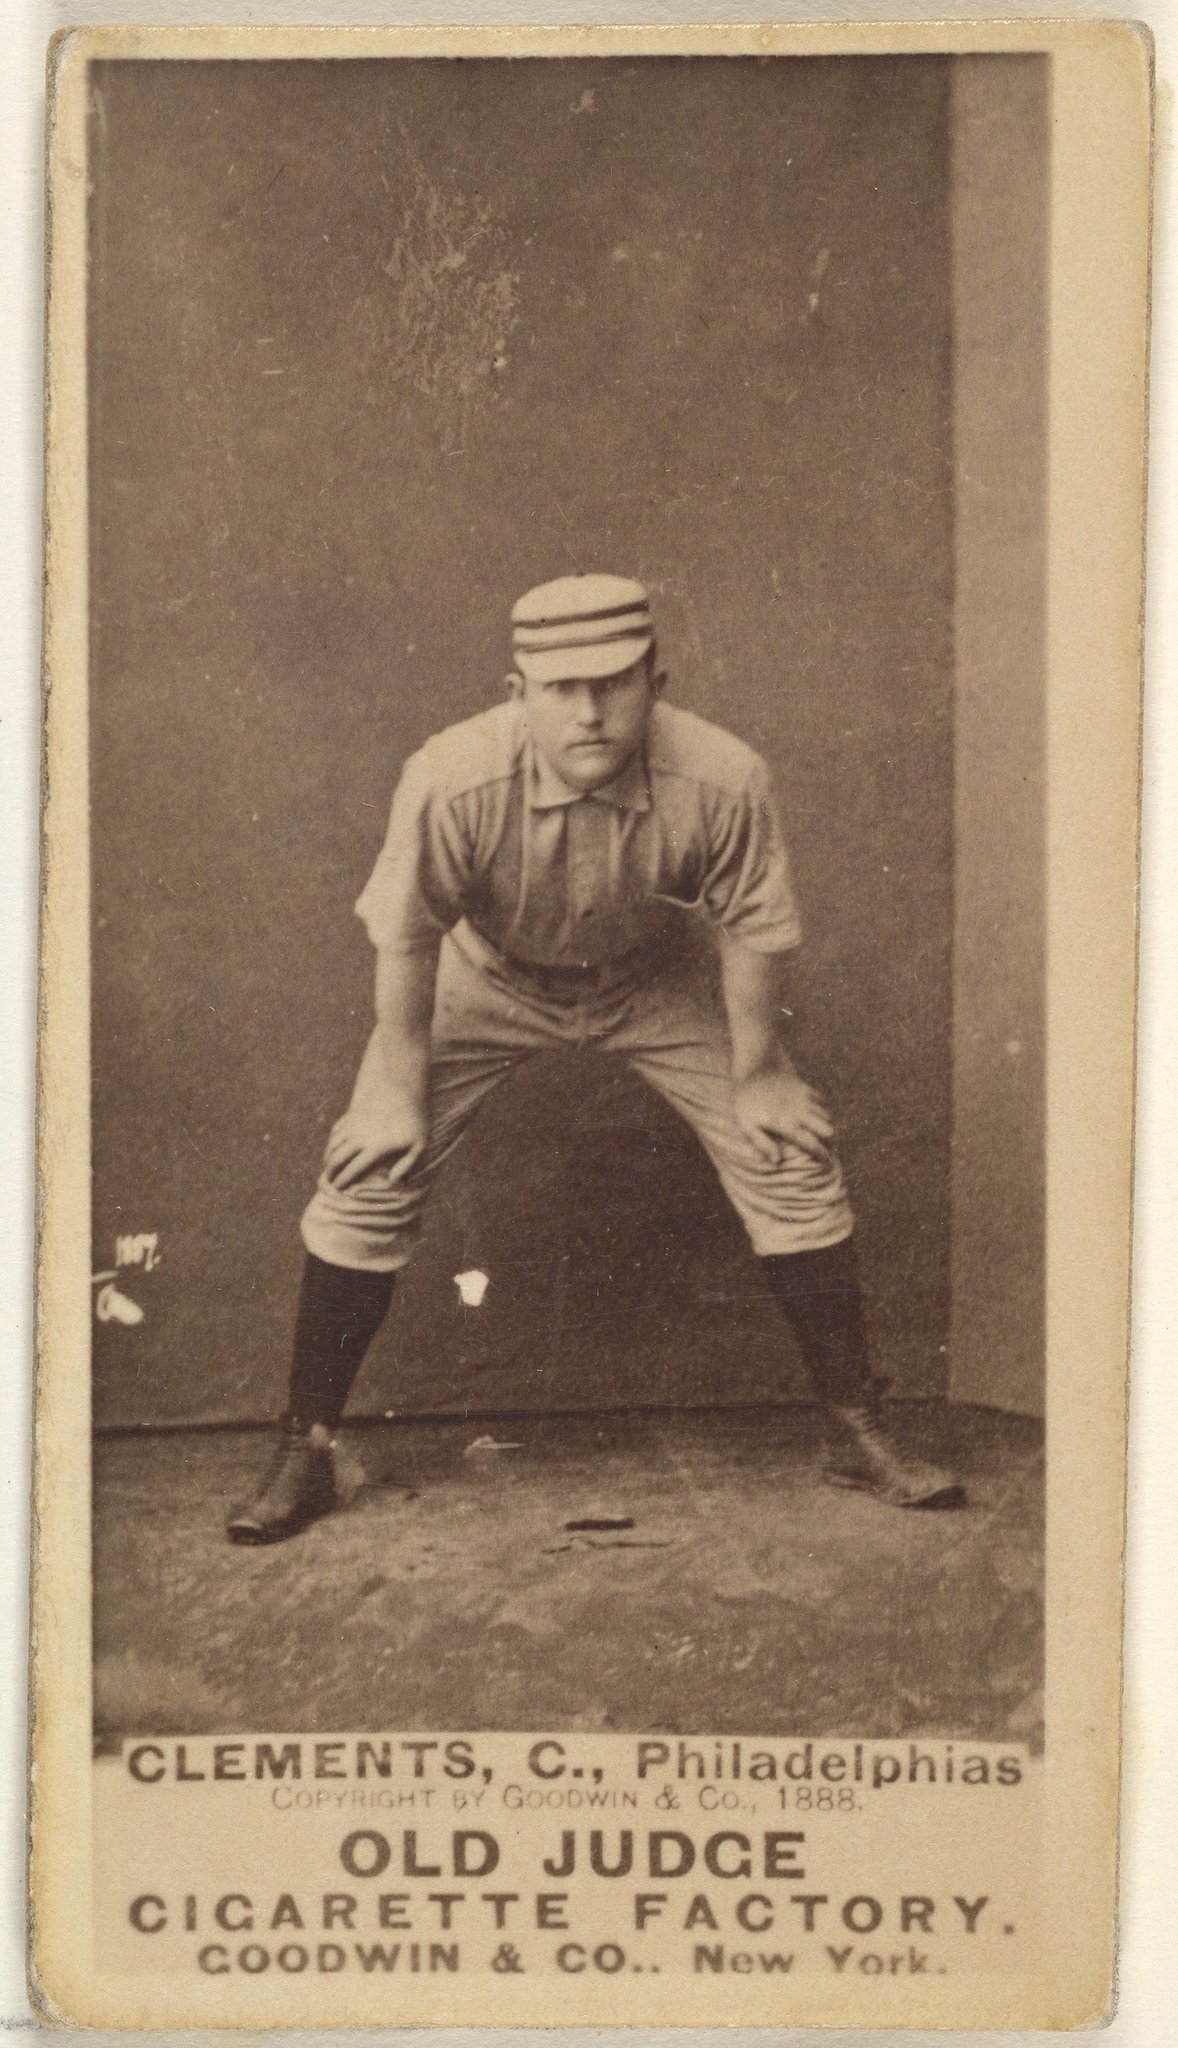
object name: baseball card, photograph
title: John J. "Jack" Clements, Catcher, Philadelphia, from the Old Judge series (N172) for Old Judge Cigarettes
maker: goodwin & company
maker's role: publisher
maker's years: 1850-1950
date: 1888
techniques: albumen silver print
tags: men,portraits,baseball,athletes